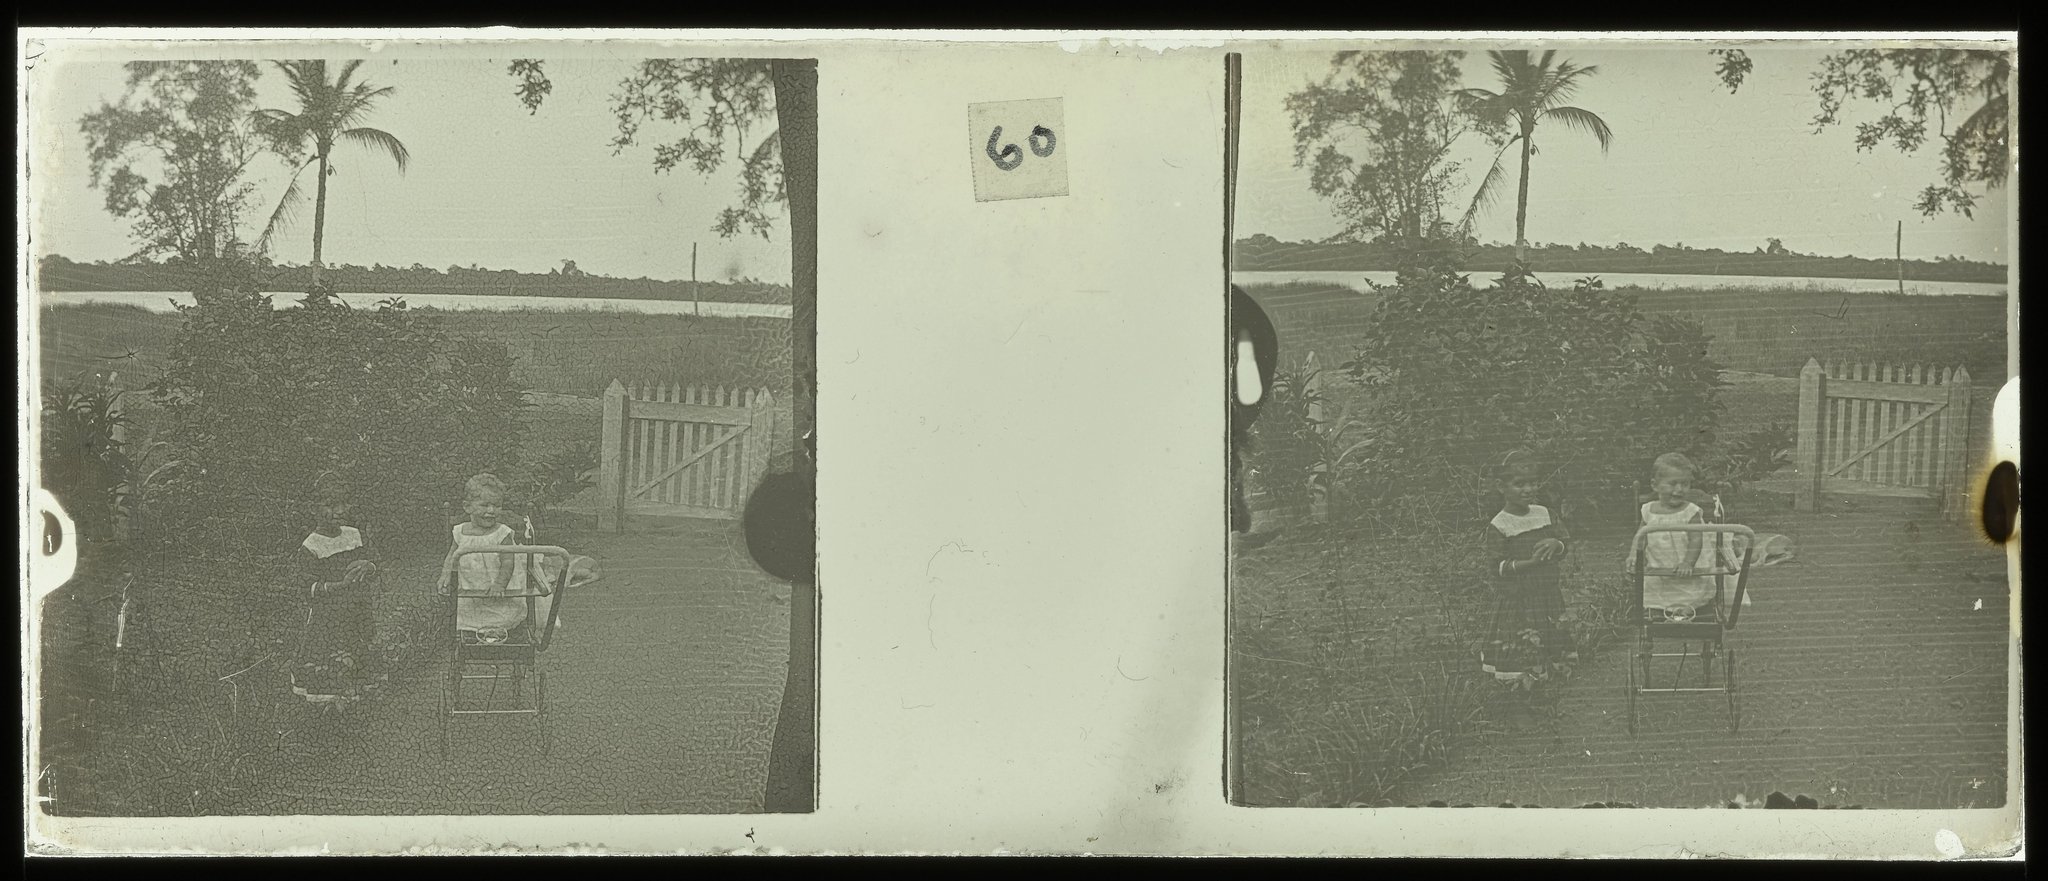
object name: stereograph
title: Plantage Accaribo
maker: theodoor brouwers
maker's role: amateurfotograaf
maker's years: 1874-1932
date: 1913-1930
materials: glass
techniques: photography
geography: suriname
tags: amsterdam, theodoor brouwers, plantation, suriname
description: In de periode 1911-1932 woonde op plantage Accaribo in Suriname de familie Brouwers van wie de foto's afkomstig zijn. Rond 1910 vond Theodoor Brouwers werk op plantage Accaribo. In 1929 werd hij eigenaar van de plantage. Op Accaribo werden in zijn tijd bananen geproduceerd en wat koffie.